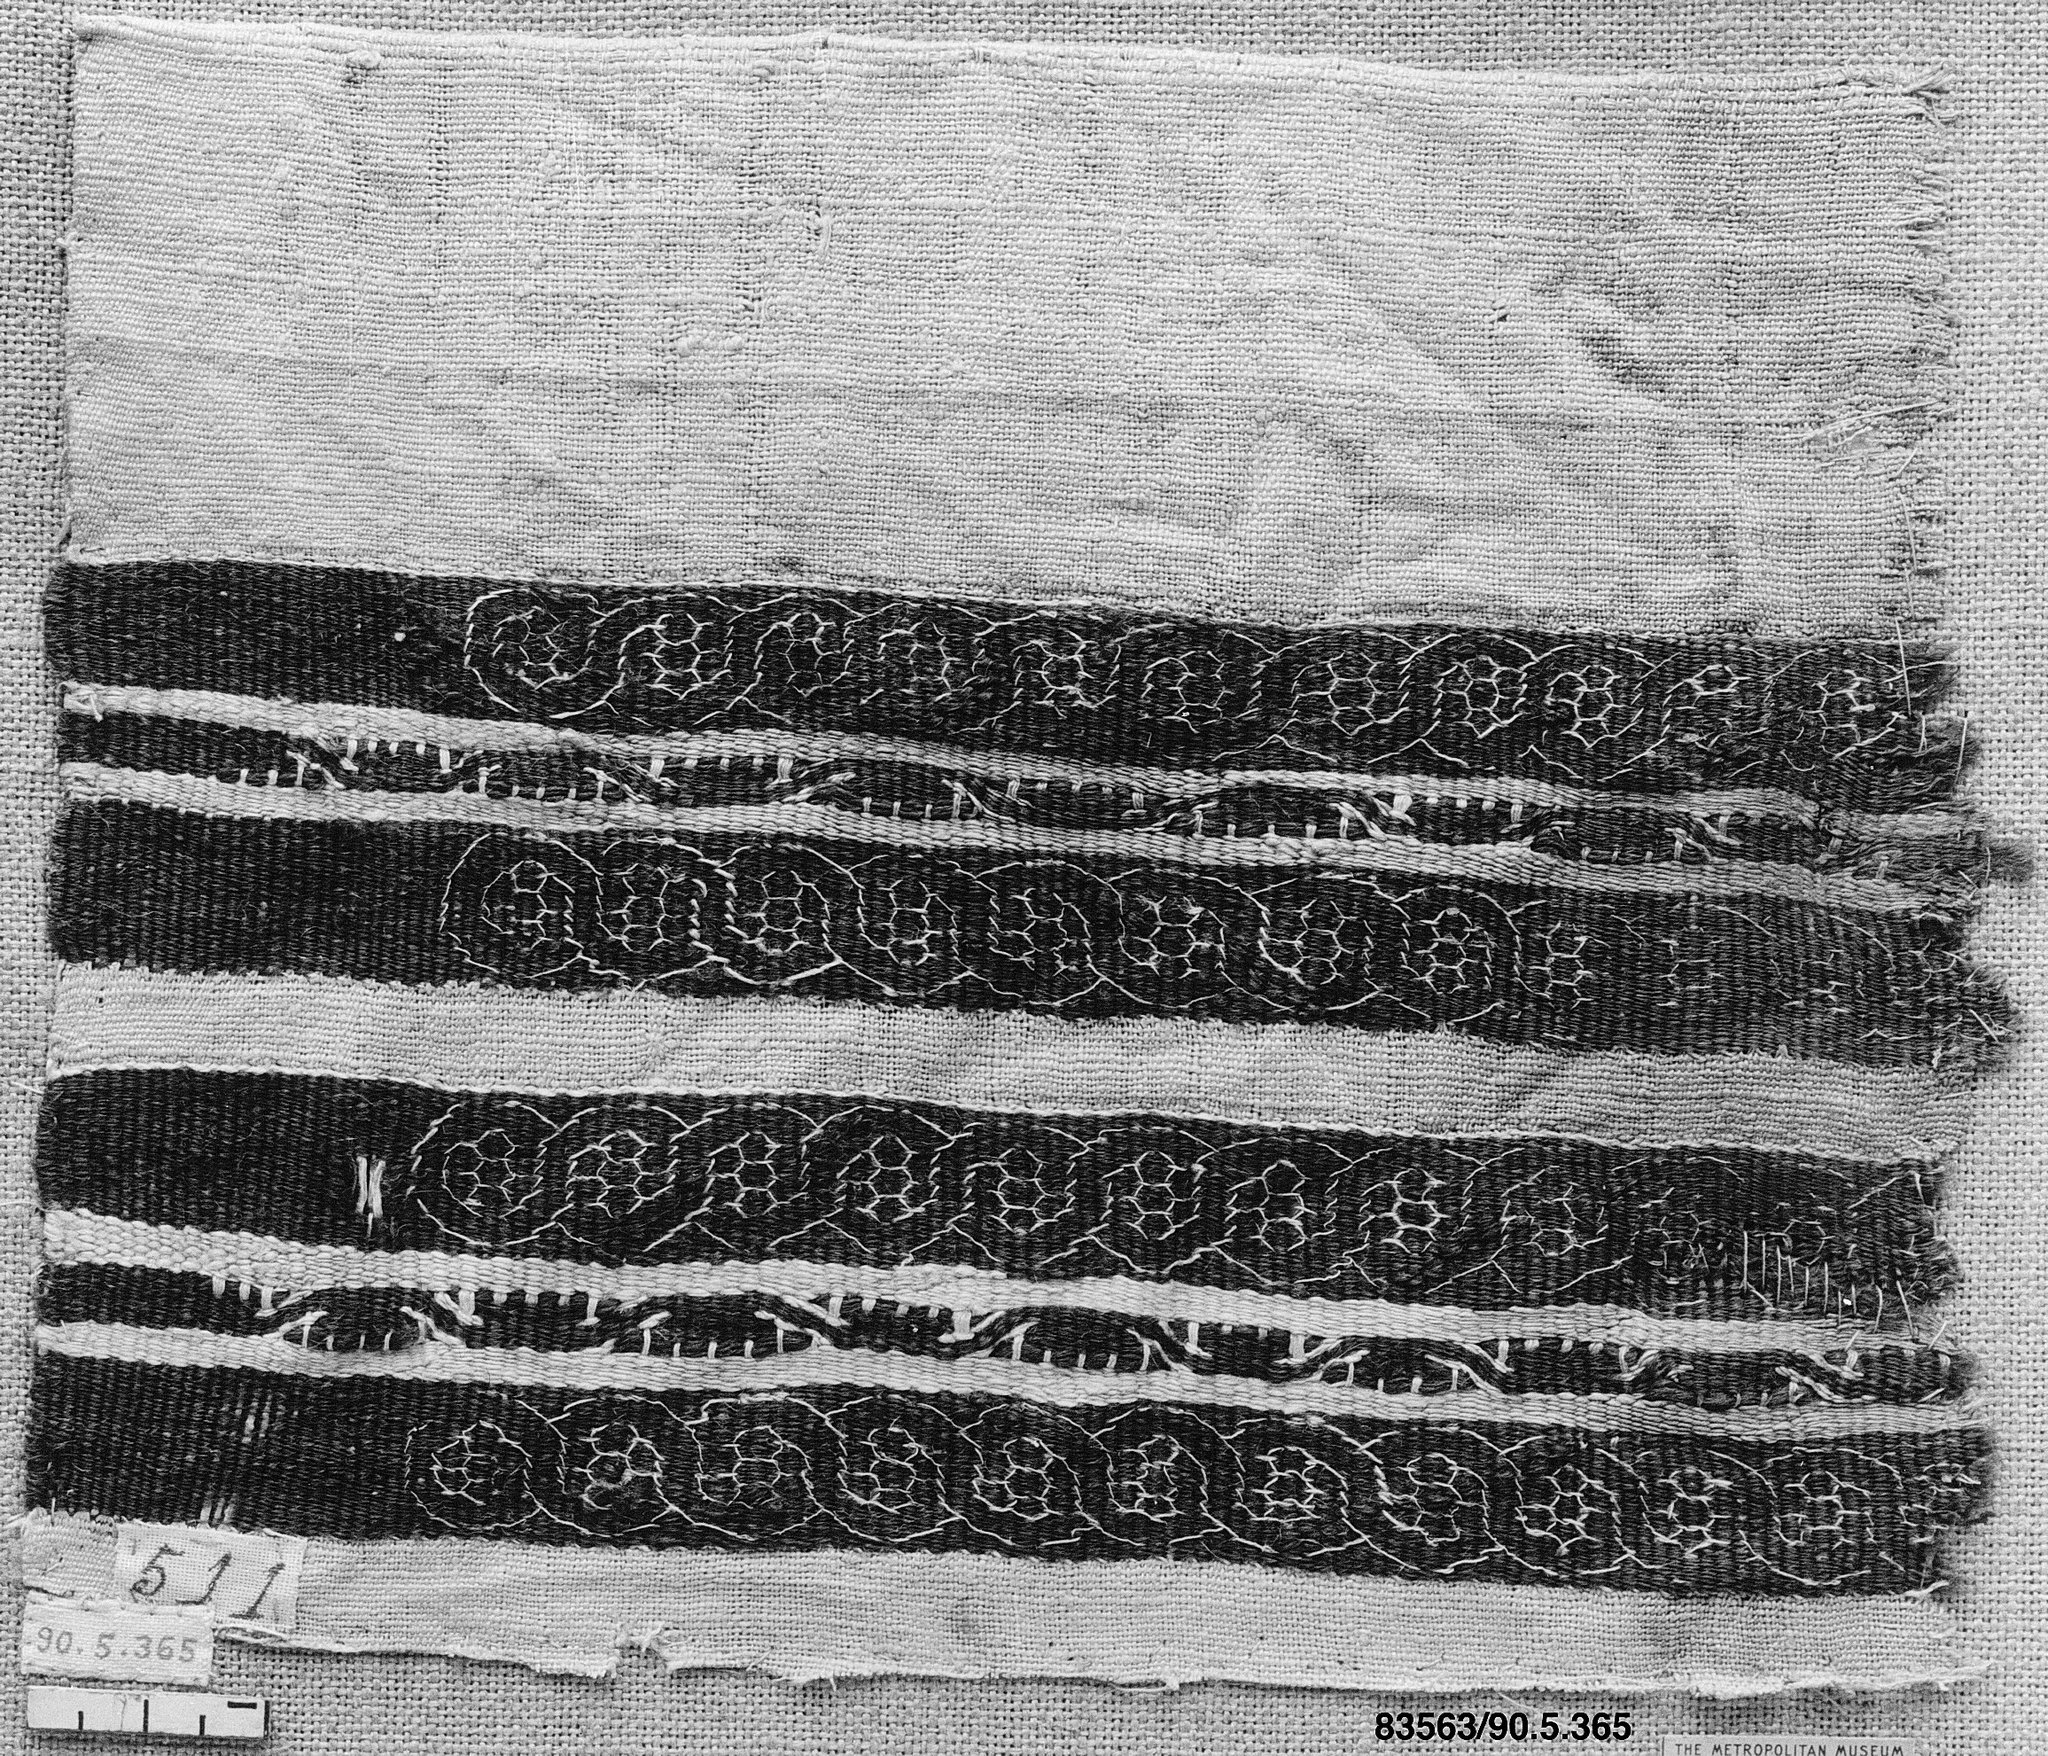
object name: textile fragment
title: Fragment of a Tunic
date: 201-400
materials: linen, wool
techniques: weave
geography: egypt